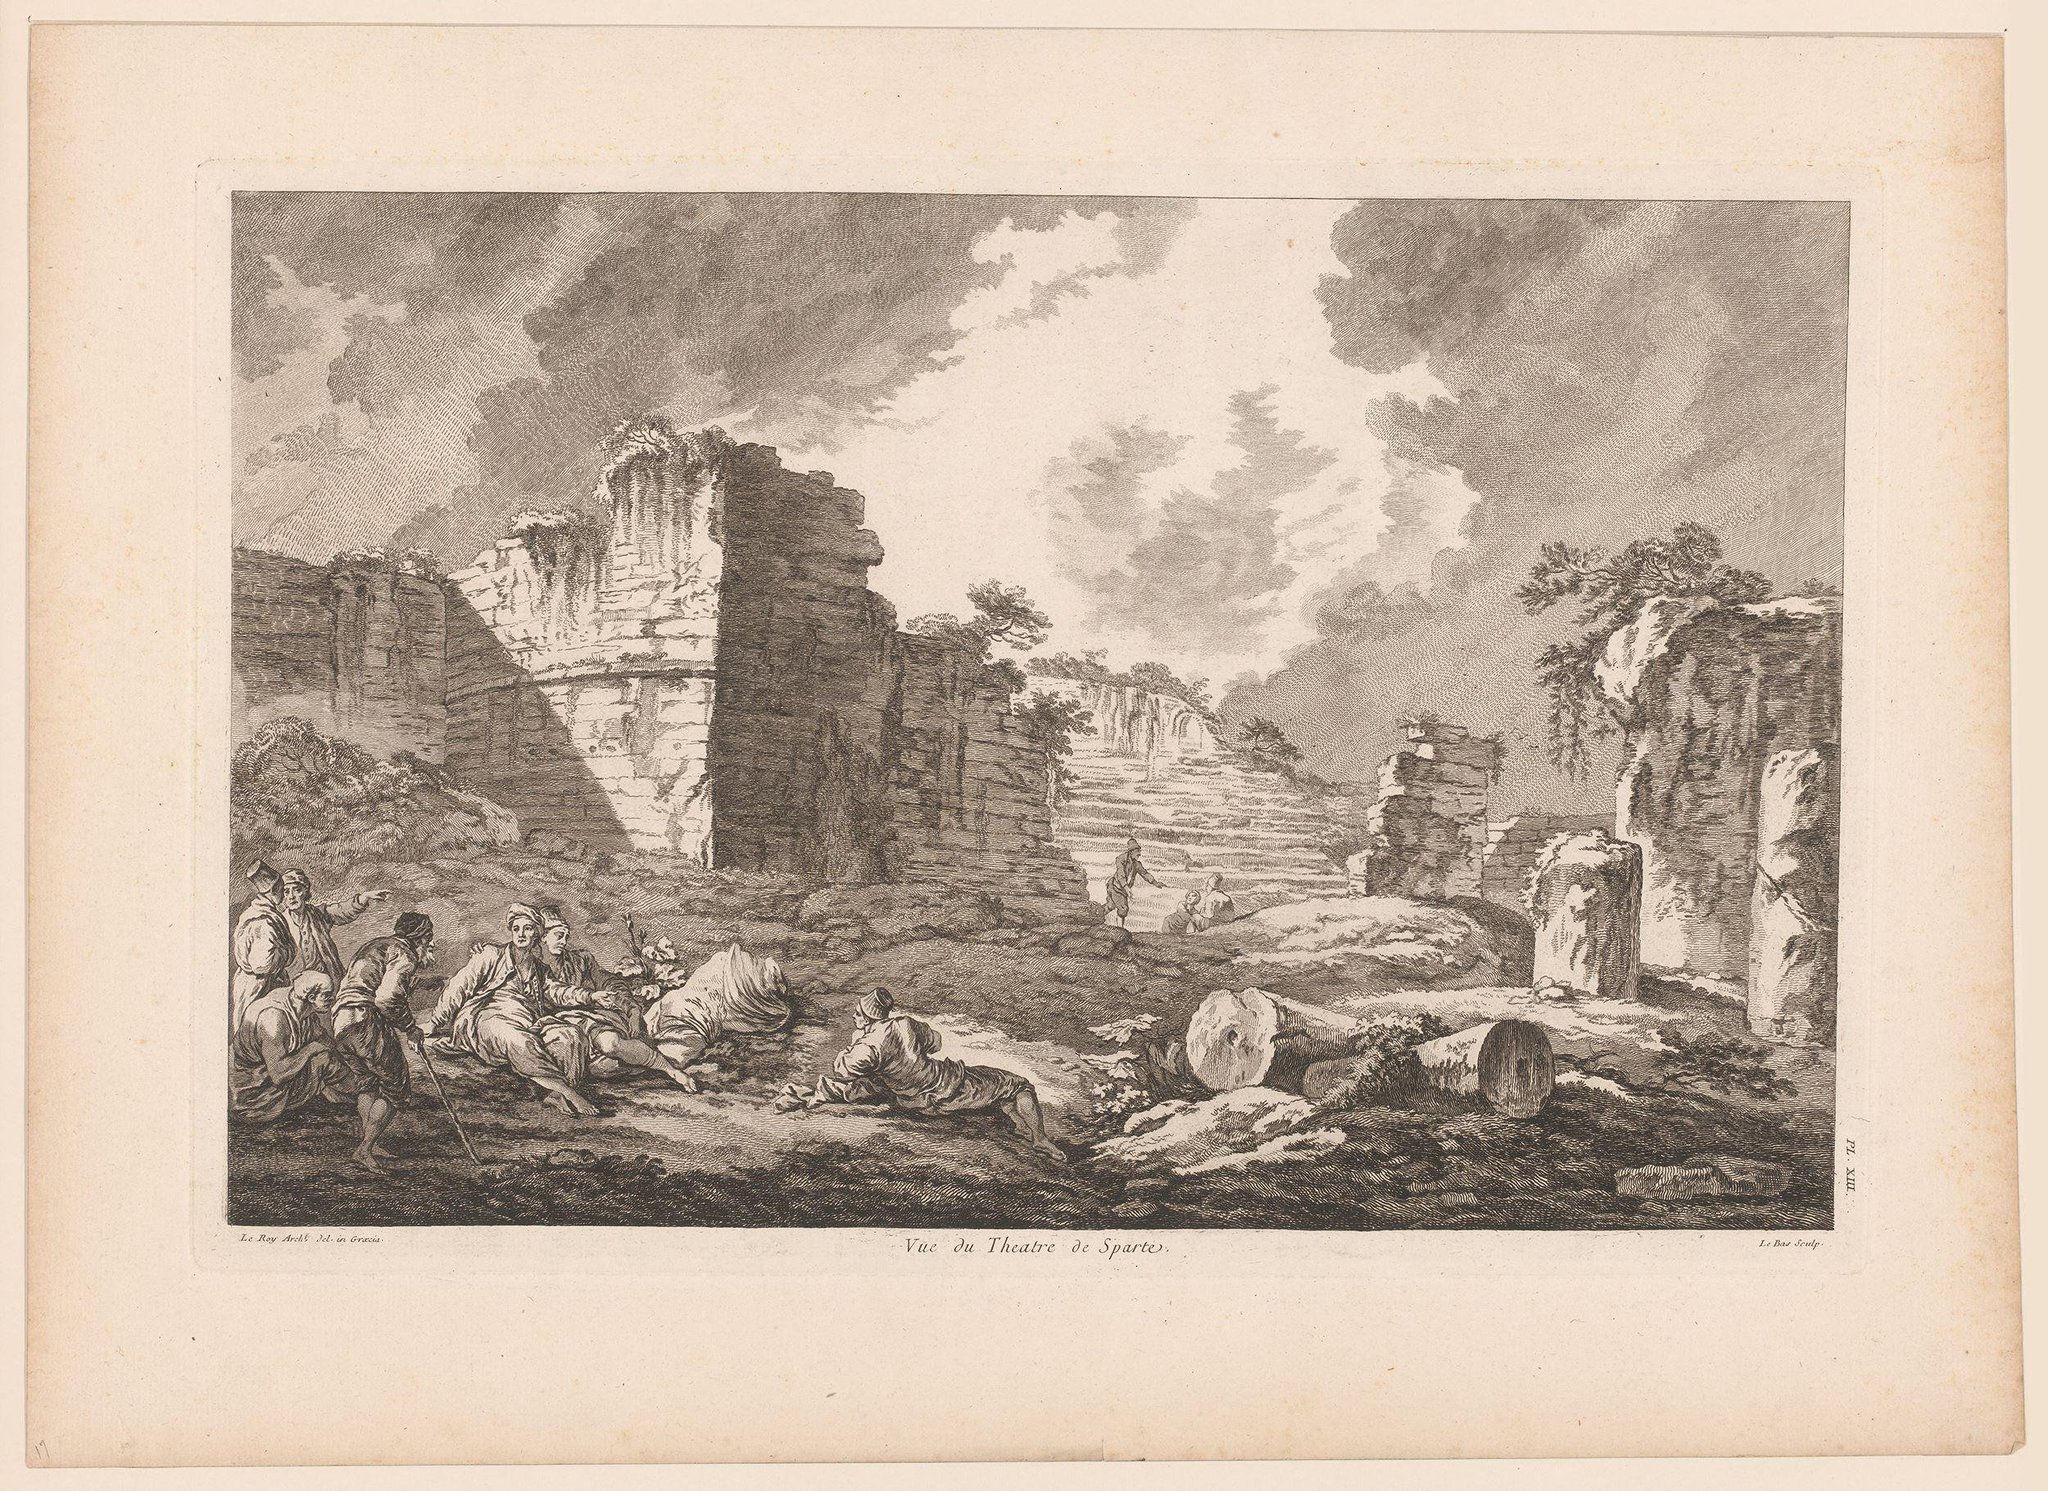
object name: book illustration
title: Vue du Theatre de Sparte.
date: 1758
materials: paper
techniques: etching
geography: greece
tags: ruin of a building ~ architecture, amphitheatre, landscape with ruins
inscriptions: collector's mark: Lugt 2760, collector's mark: Lugt 2228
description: Prent uit: Le Roy, Julien. Ruines des plus beaux monuments de la Grêce. Parijs: Guérin & de La Tour, 1758. Dit betreft plaat XIII.